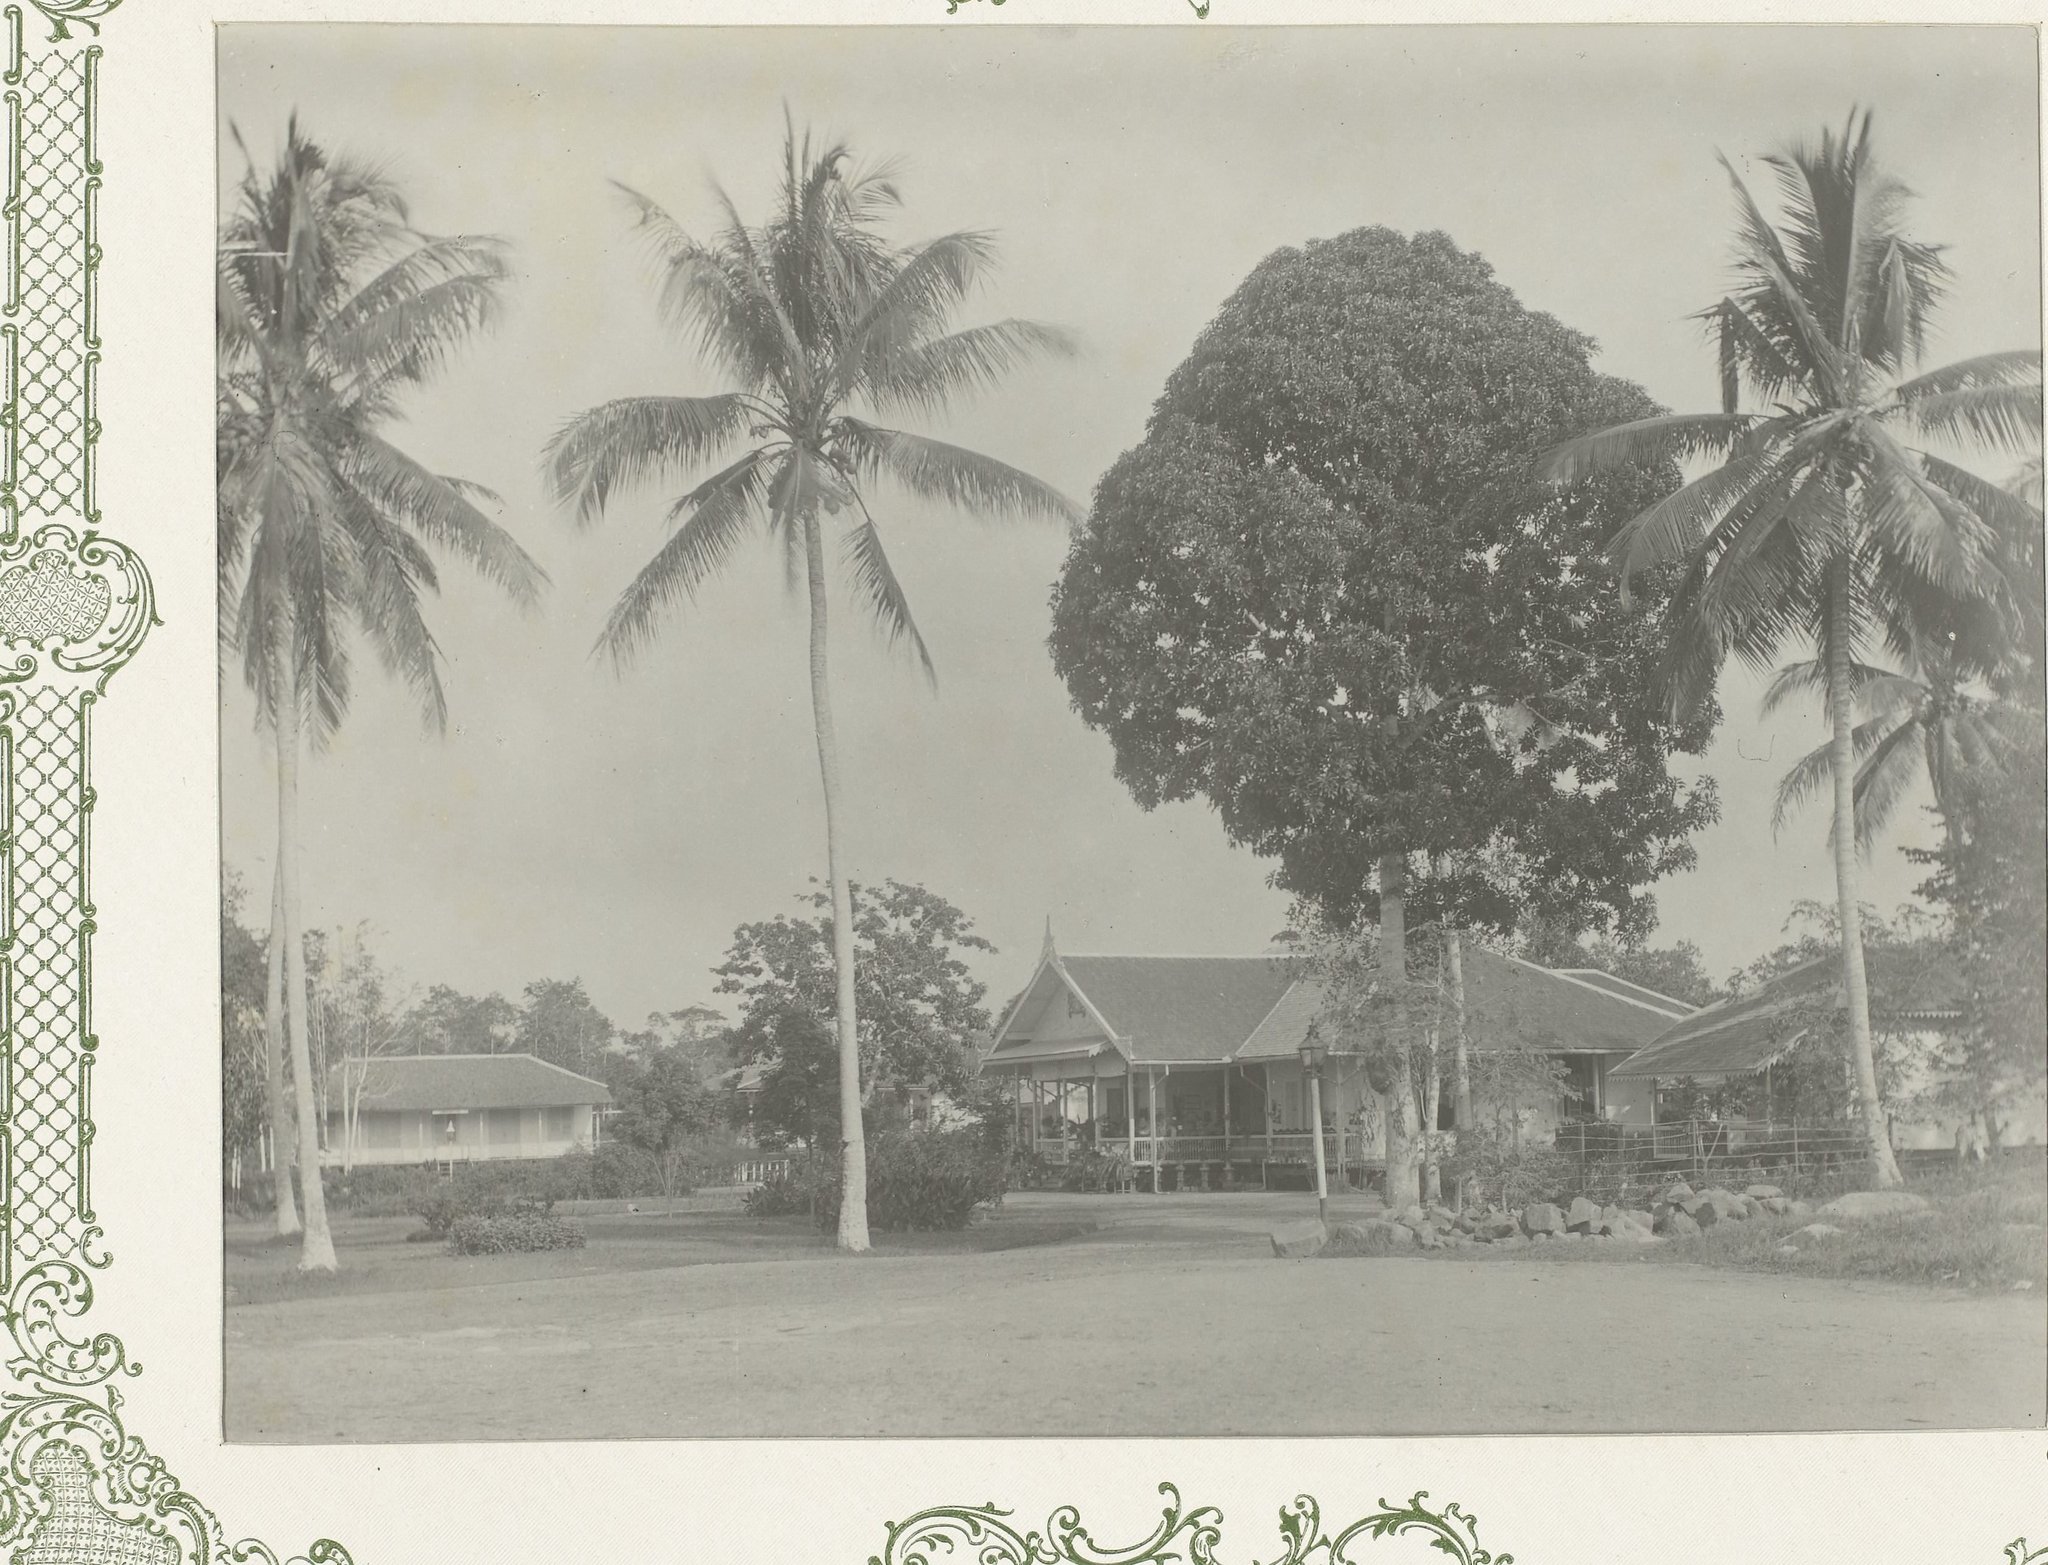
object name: photograph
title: Gebouwen onder bomen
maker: Anonymous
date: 1903-1907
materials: paper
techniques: gelatin silver print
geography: kalimantan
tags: landscapes in tropical and sub-tropical regions, borneo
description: Gezicht op enkele gebouwen onder palmbomen in een plaats op Borneo. Foto in het fotoalbum over de oliewinning op Borneo door de Koninklijke Nederlandsche Petroleum Maatschappij (KNPM) in de jaren 1903-1907.